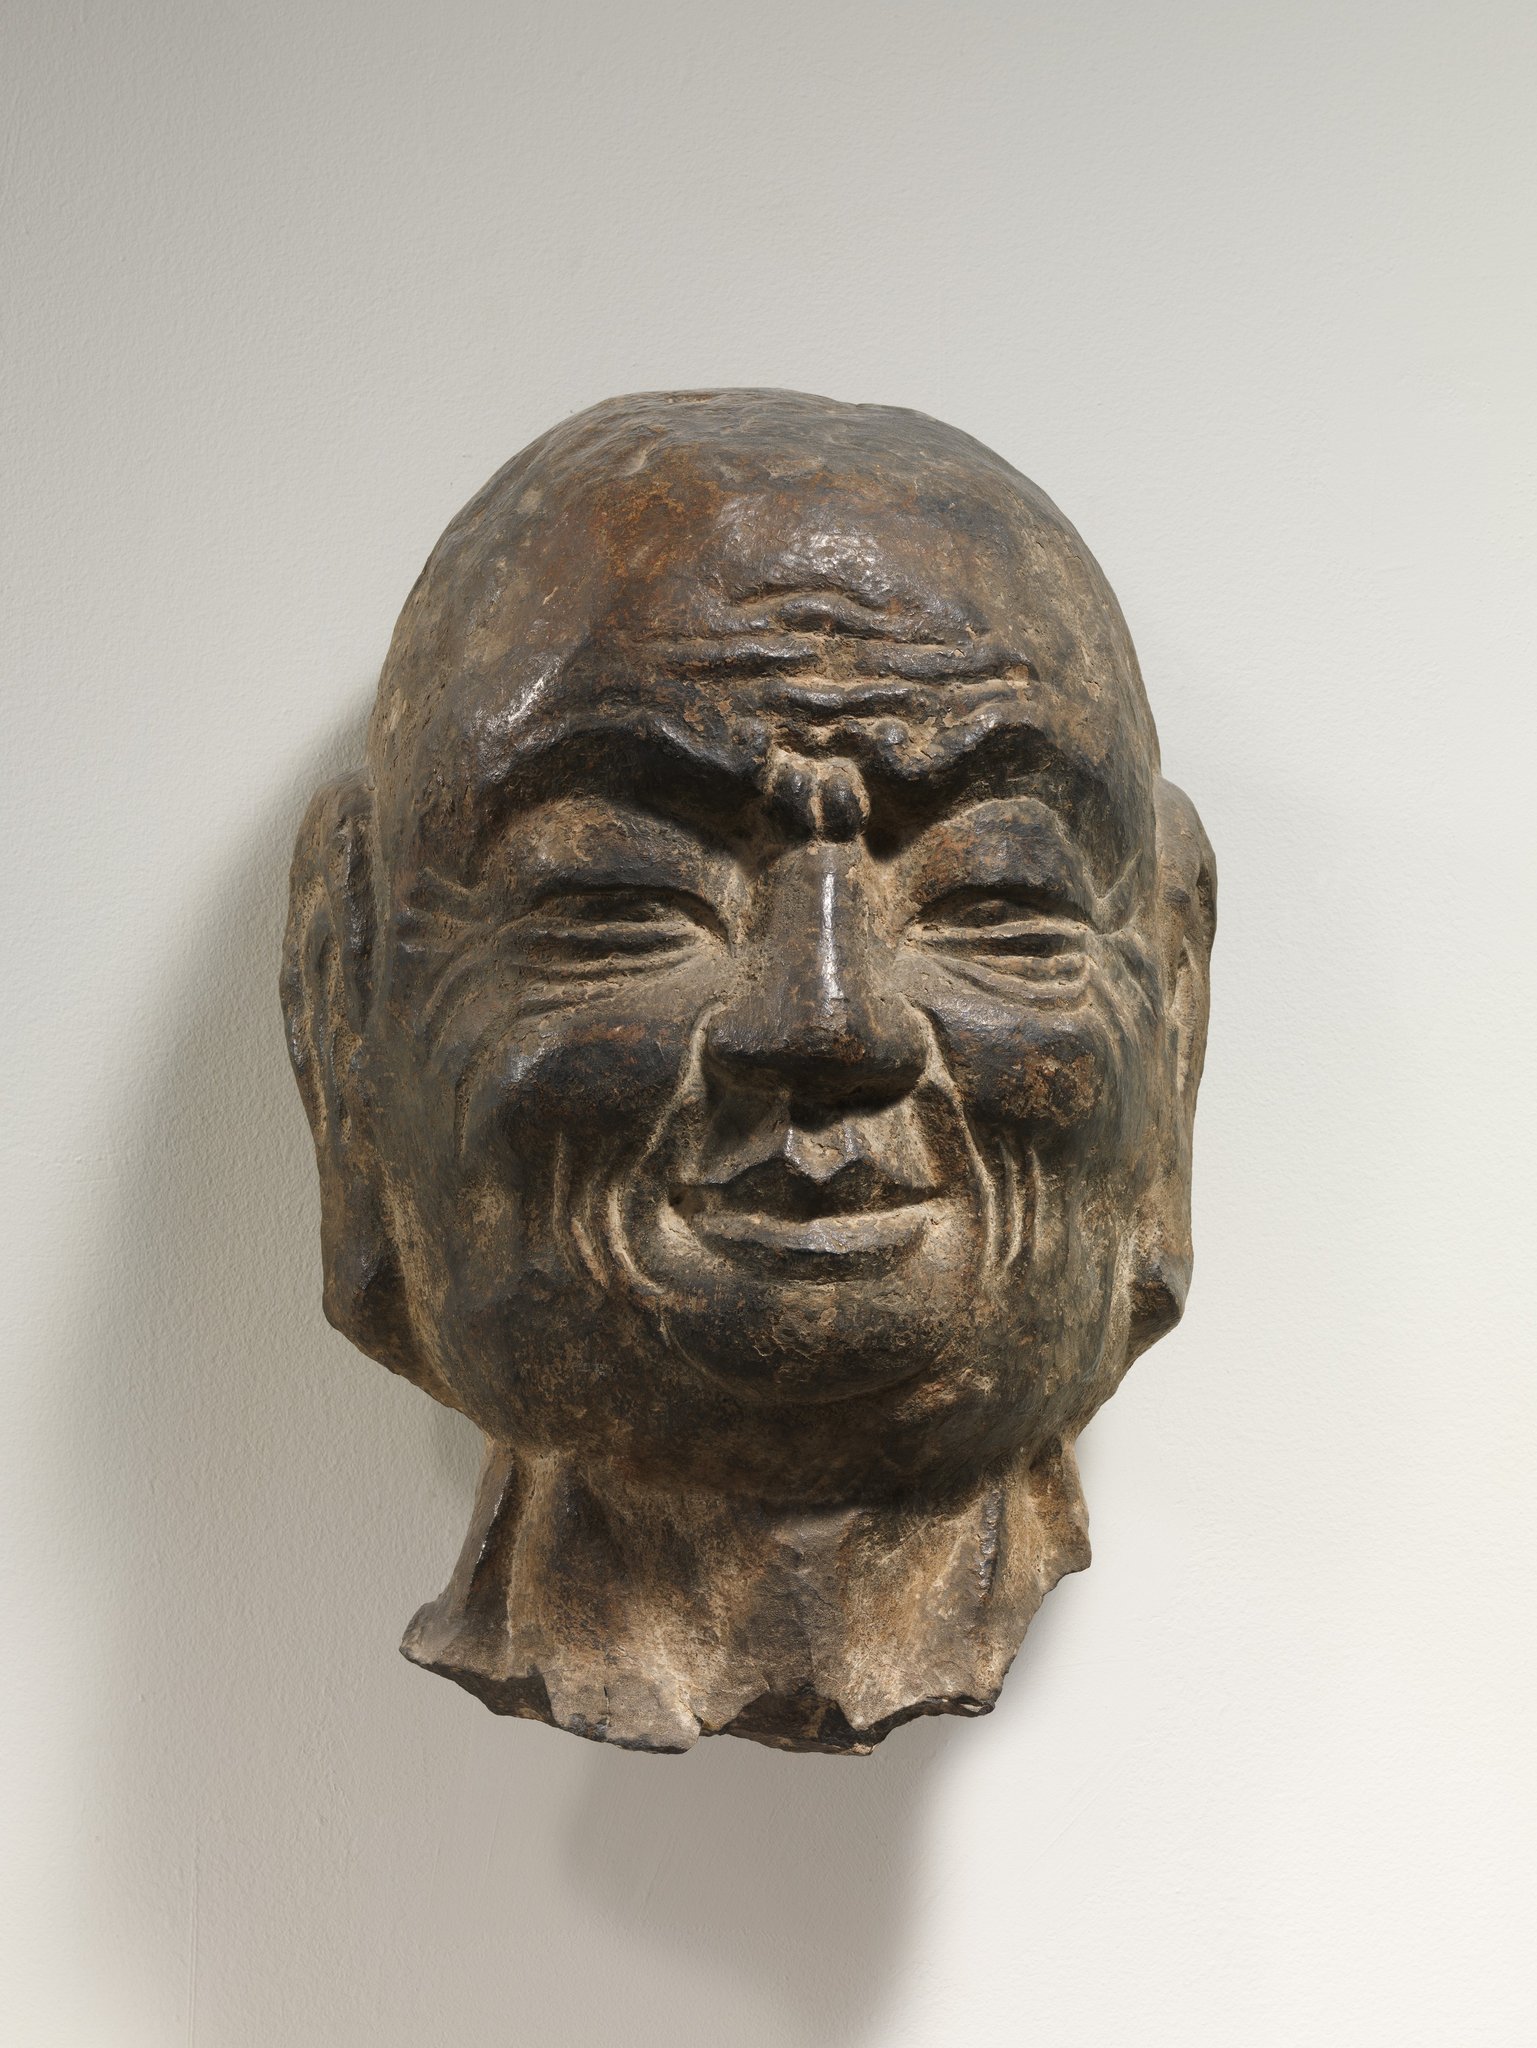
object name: head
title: Head of a Luohan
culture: chinese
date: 701-900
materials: limestone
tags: heads,buddhism